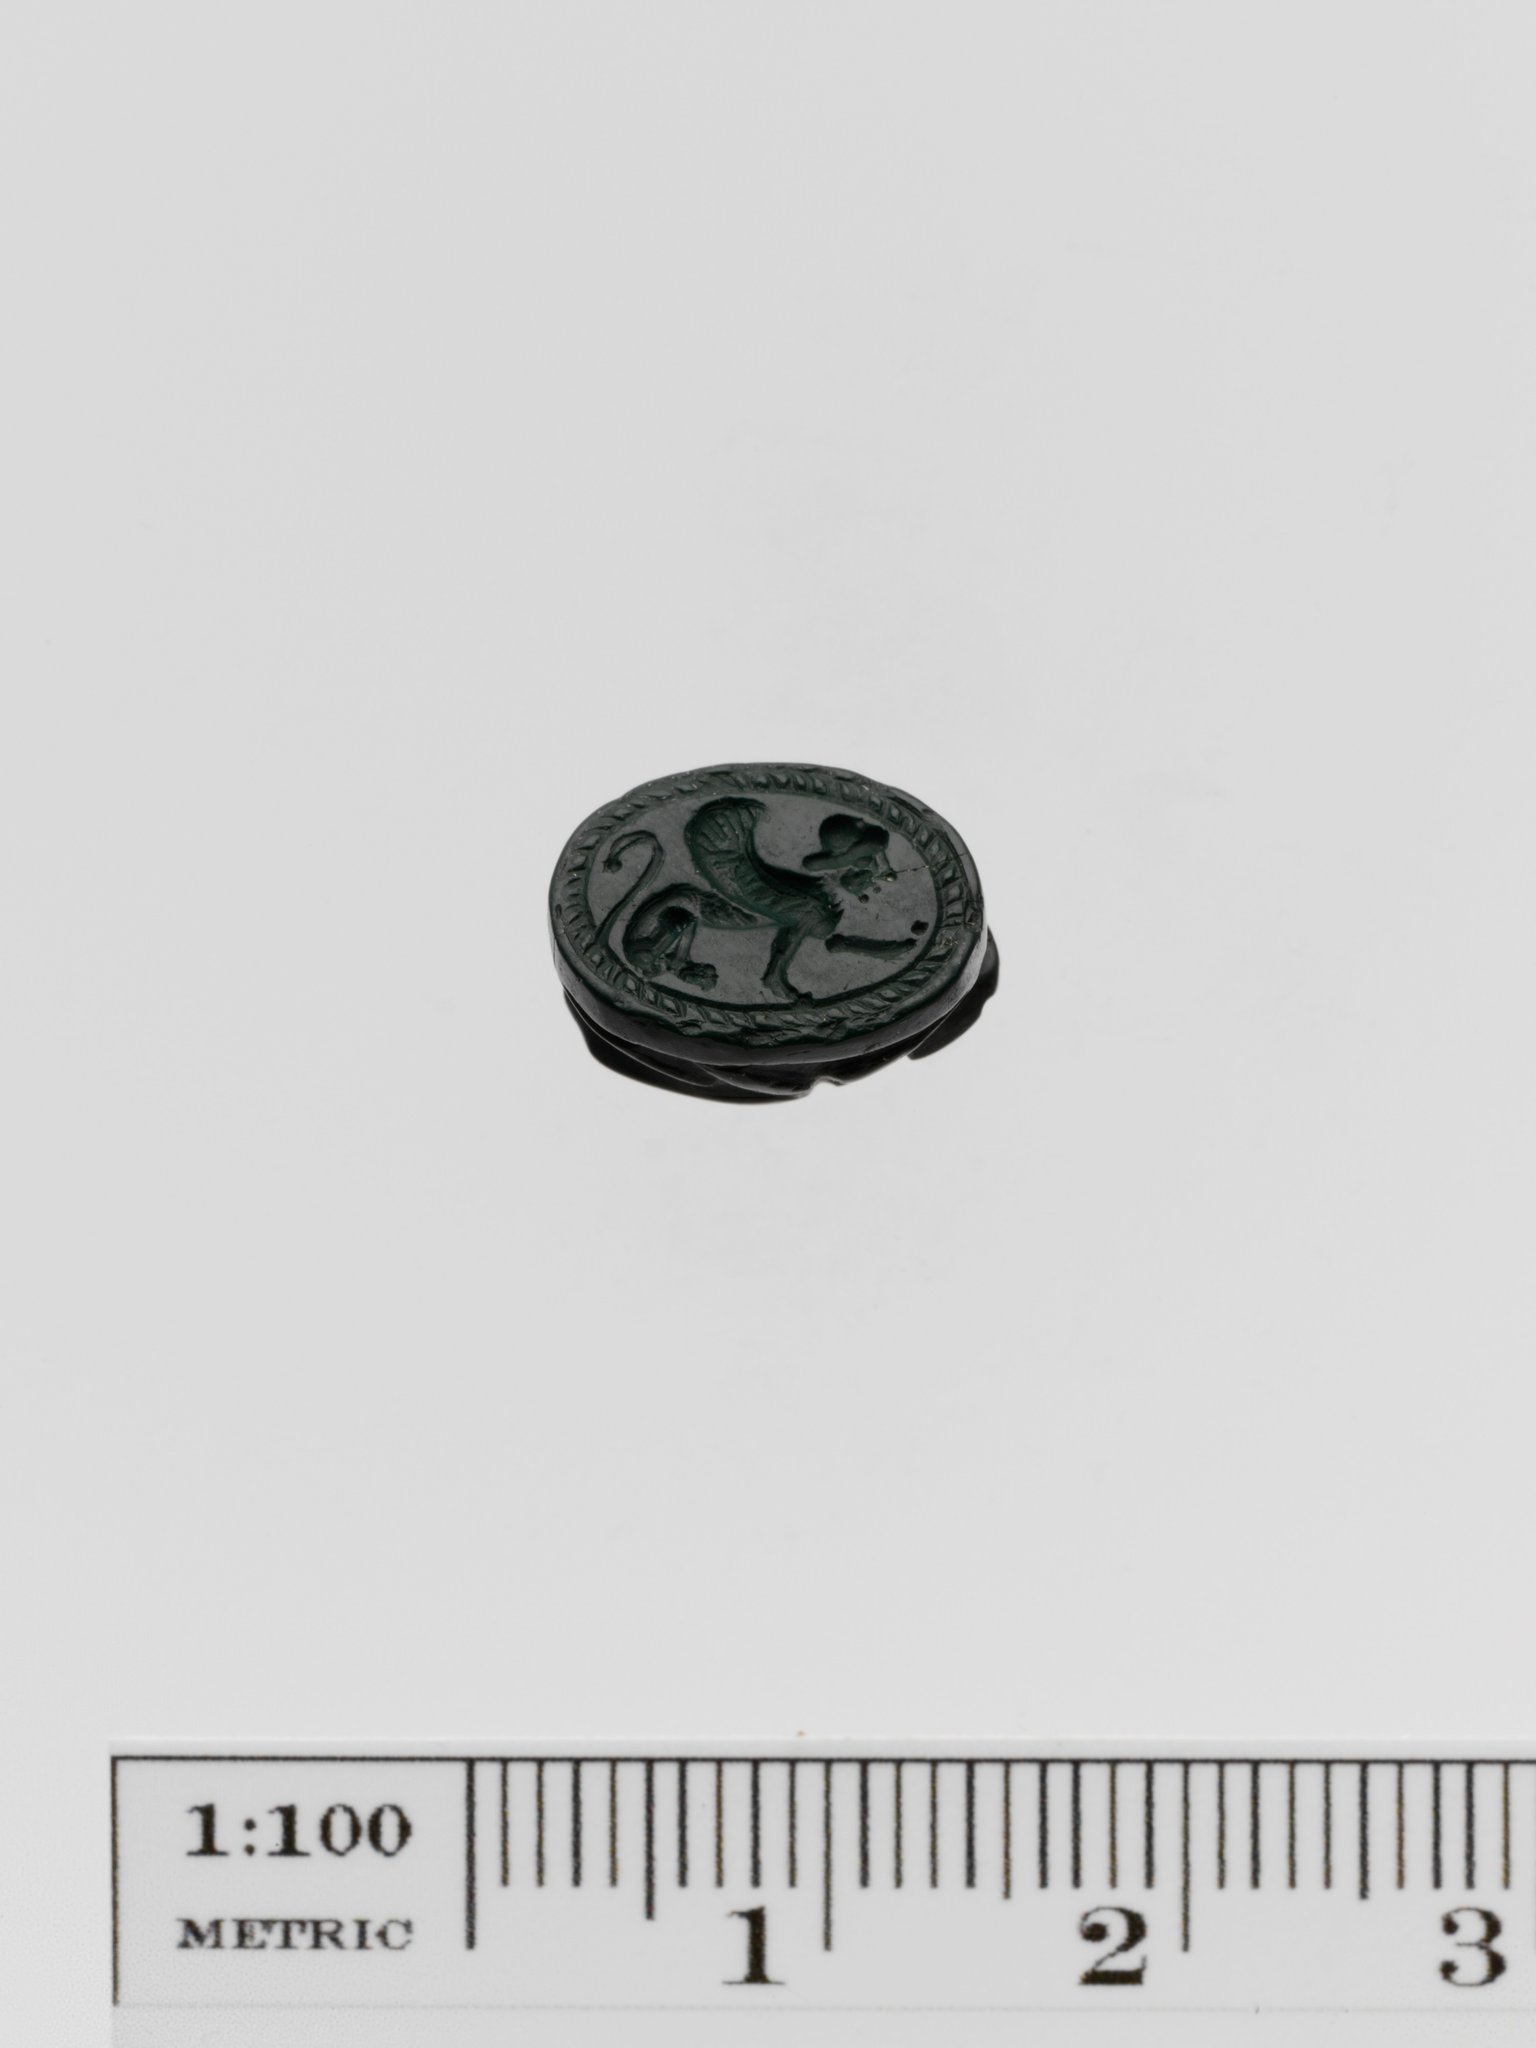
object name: scarab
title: Jasper scarab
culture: greek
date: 600-501 BCE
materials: jasper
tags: sphinx,scarabs